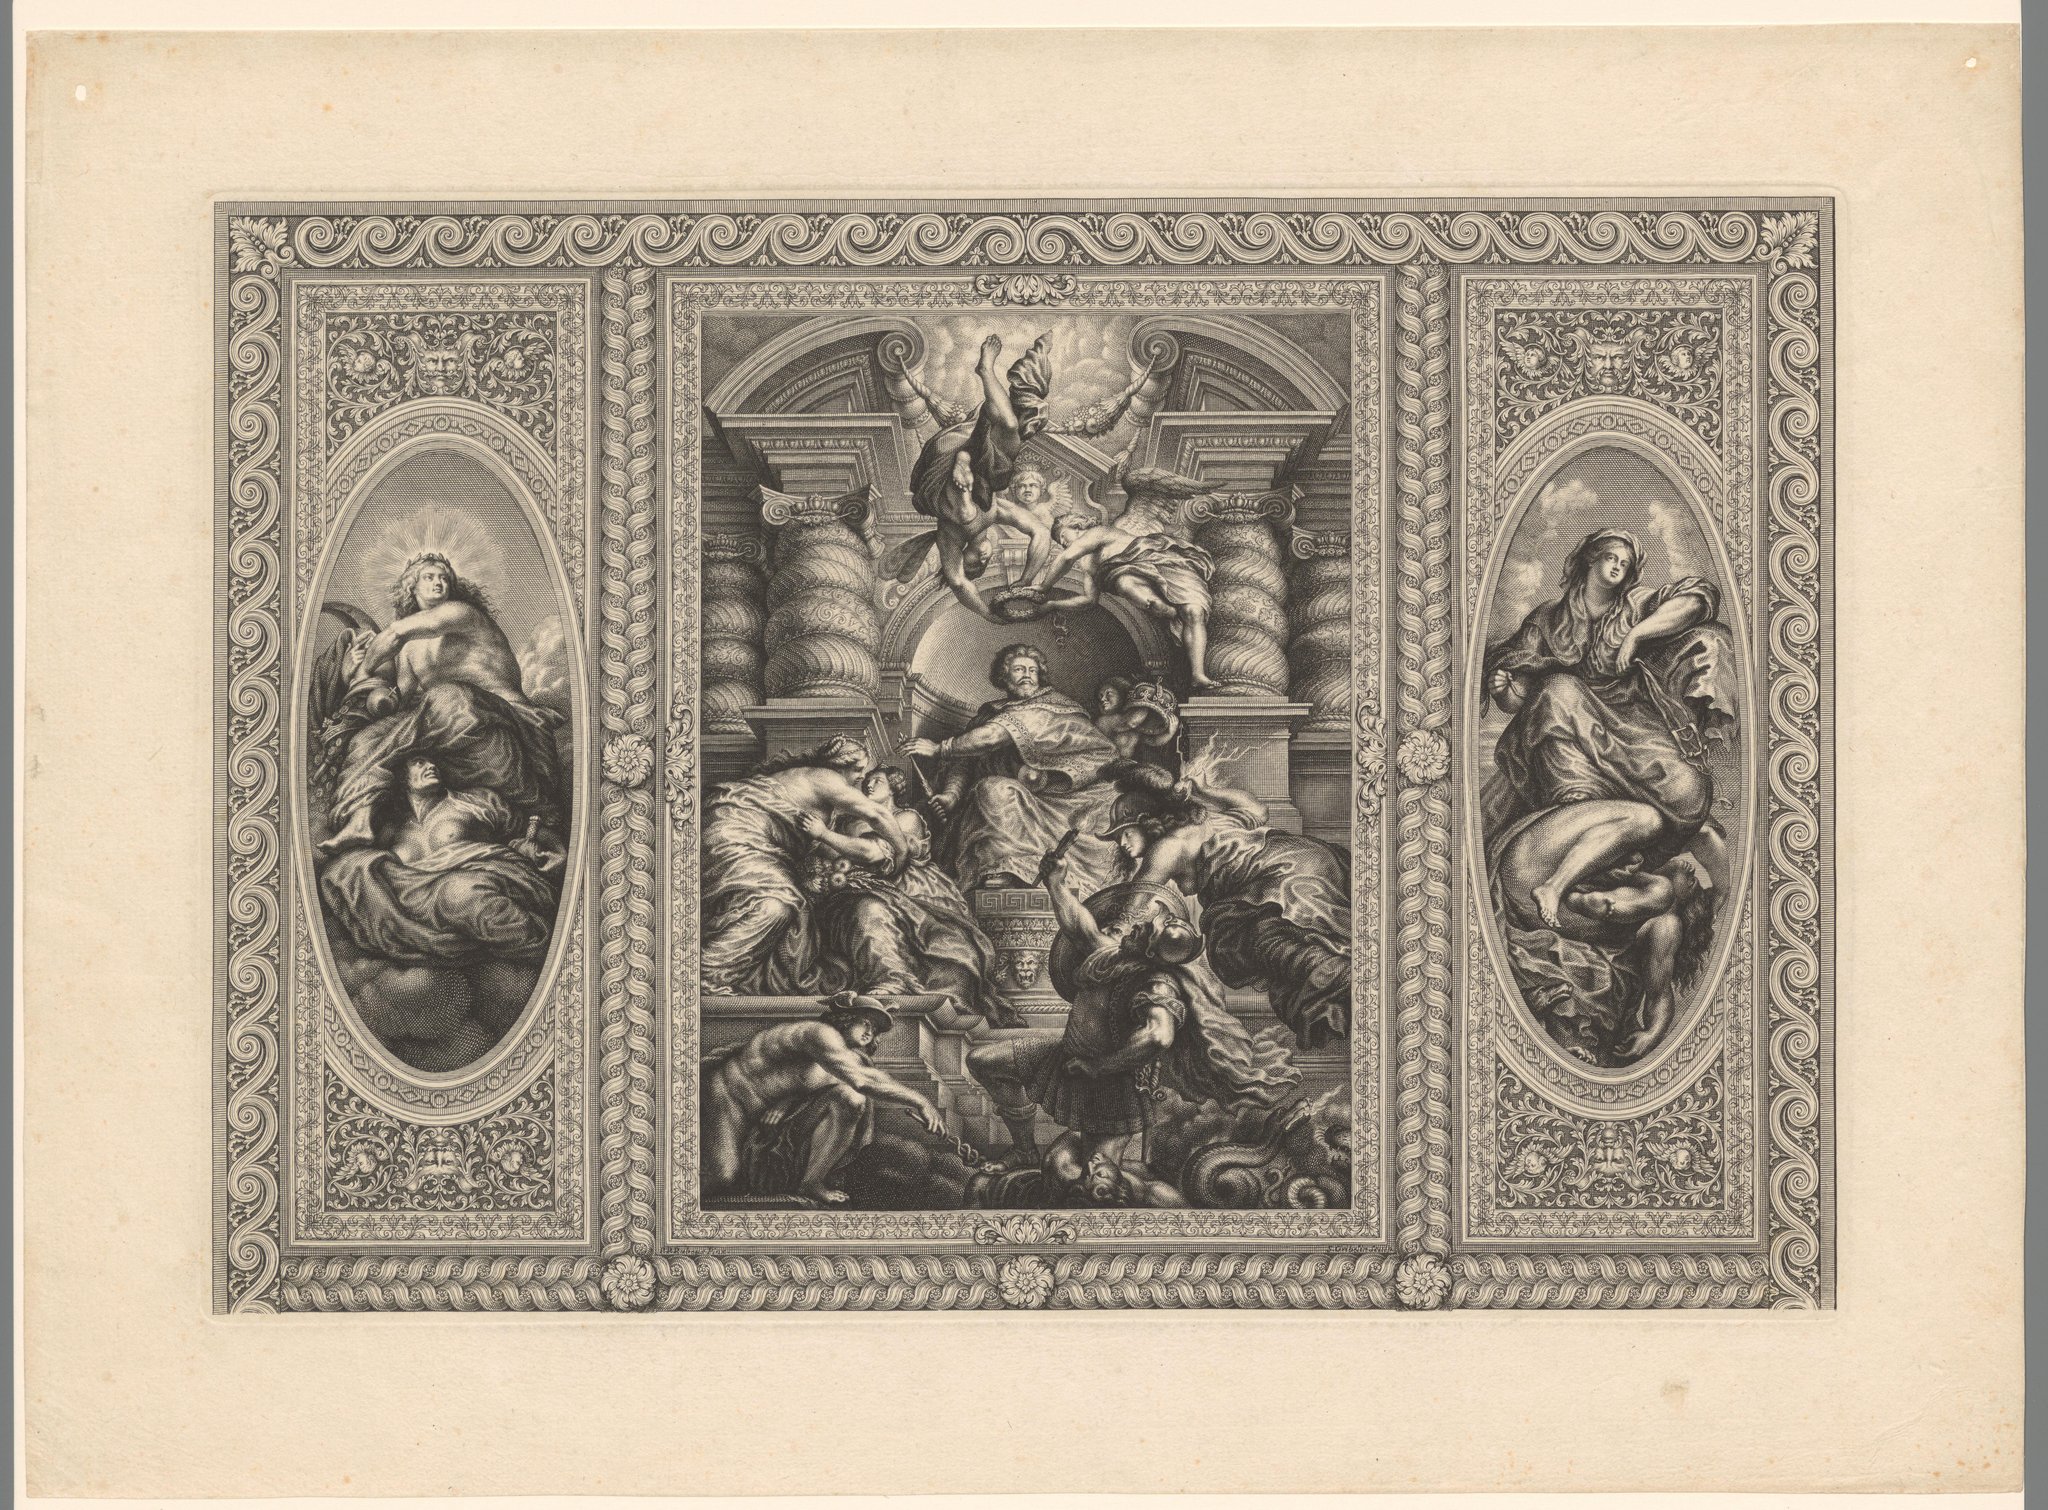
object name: print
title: Negen plafondschilderingen uit The Banqueting House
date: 1720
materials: paper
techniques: engraving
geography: london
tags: jacobus i (koning van engeland), (story of) mercury (hermes), covetousness; 'avaritia' (ripa) ~ personification of one of the seven deadly sins, freedom, liberty; 'libertà' (ripa), king, crowning the victor with laurel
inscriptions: collector's mark: Lugt 240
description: Deze prent vormt samen met RP-P-OB-18.669 en RP-P-OB-18.671 een voorstelling van de plafondschildering door Rubens, over het leven van Jacobus I.